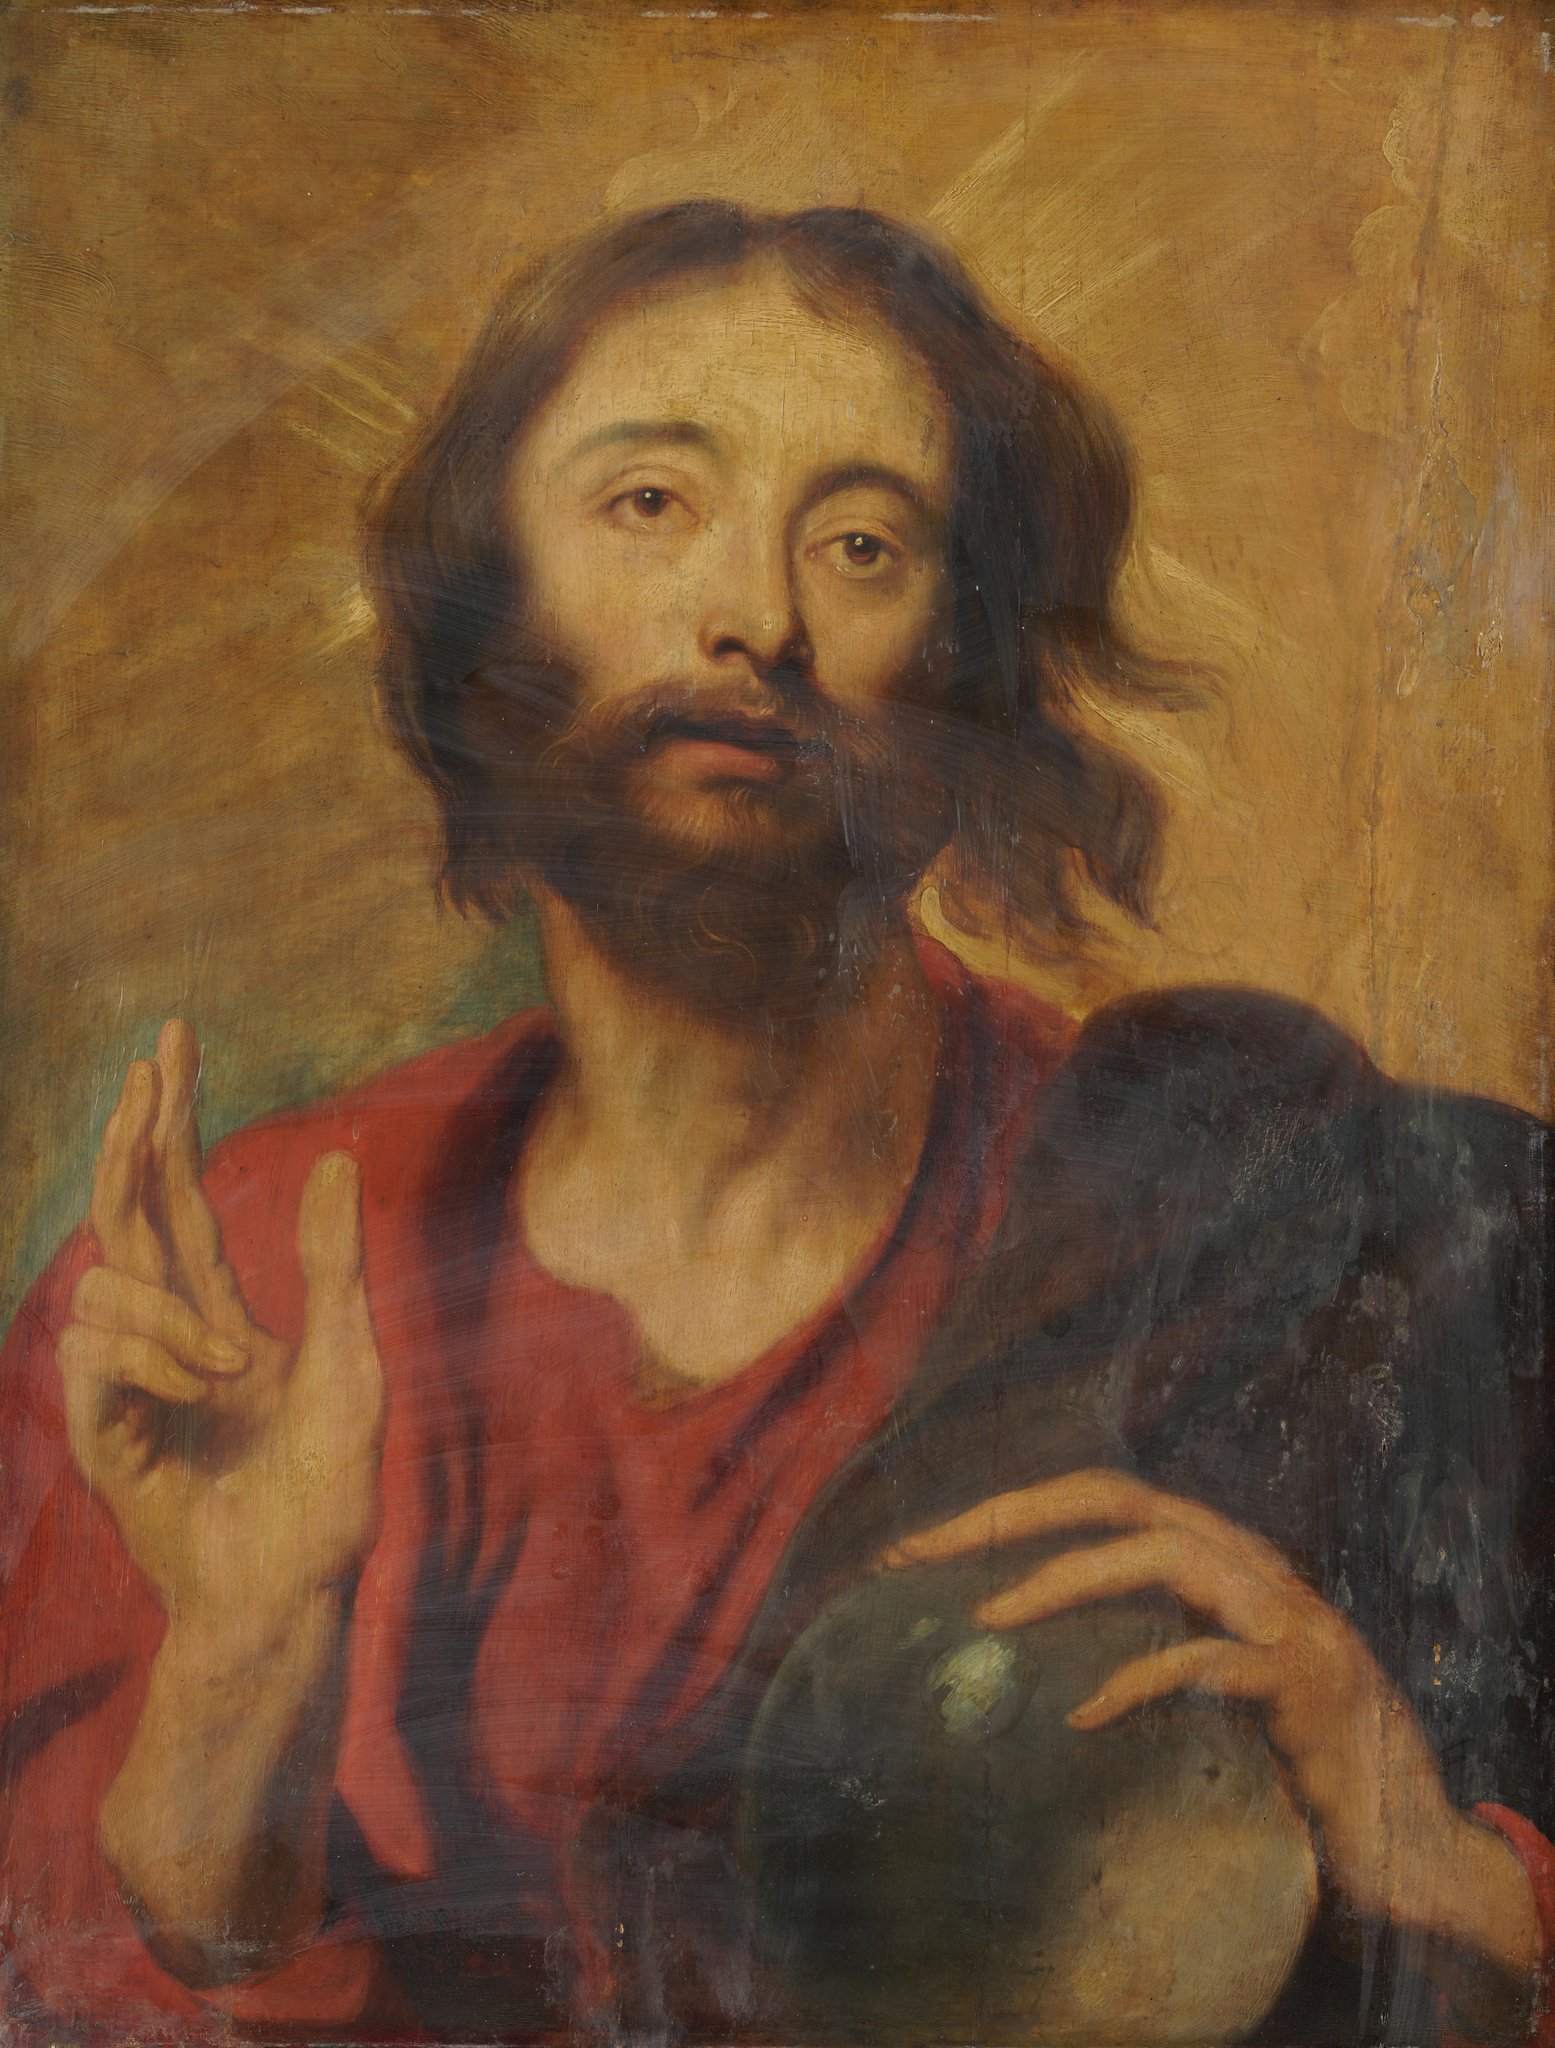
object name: painting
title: Christ as Saviour of the World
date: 1620-1630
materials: canvas, oil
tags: 'salvator mundi', making a blessing gesture; an orb in his hand or at his feet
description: Borstbeeld van Christus als Salvator Mundi. Kopie naar het origineel in Potsdam.